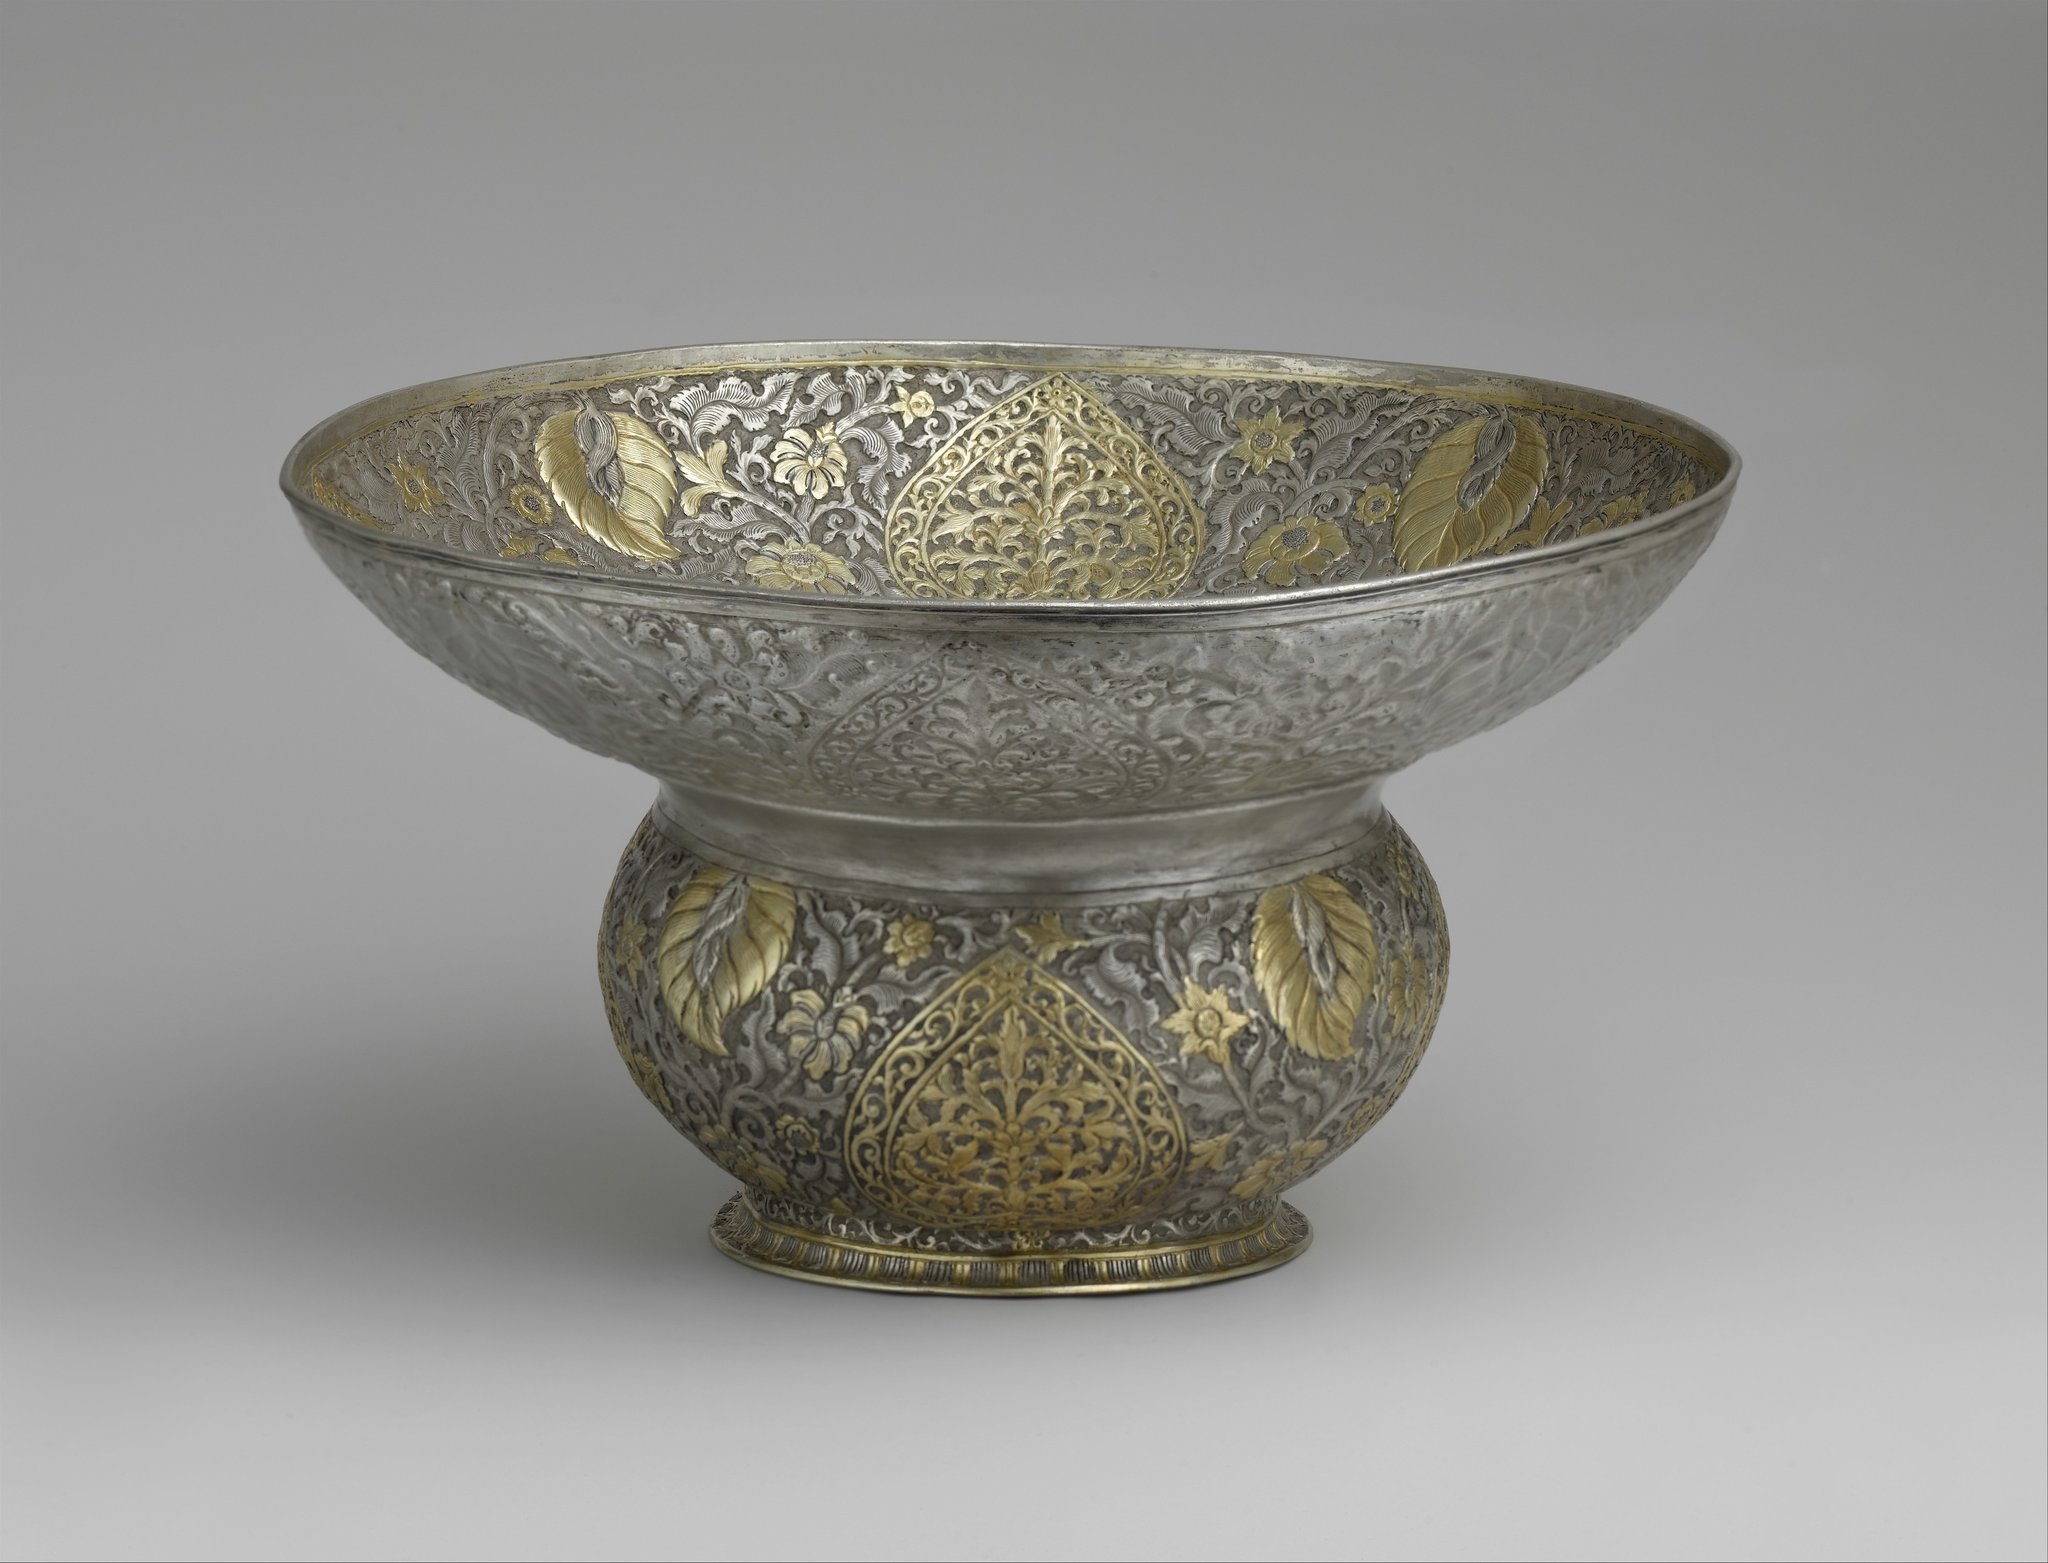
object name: basin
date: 1801-1900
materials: silver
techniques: gilding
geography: armenia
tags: leaves